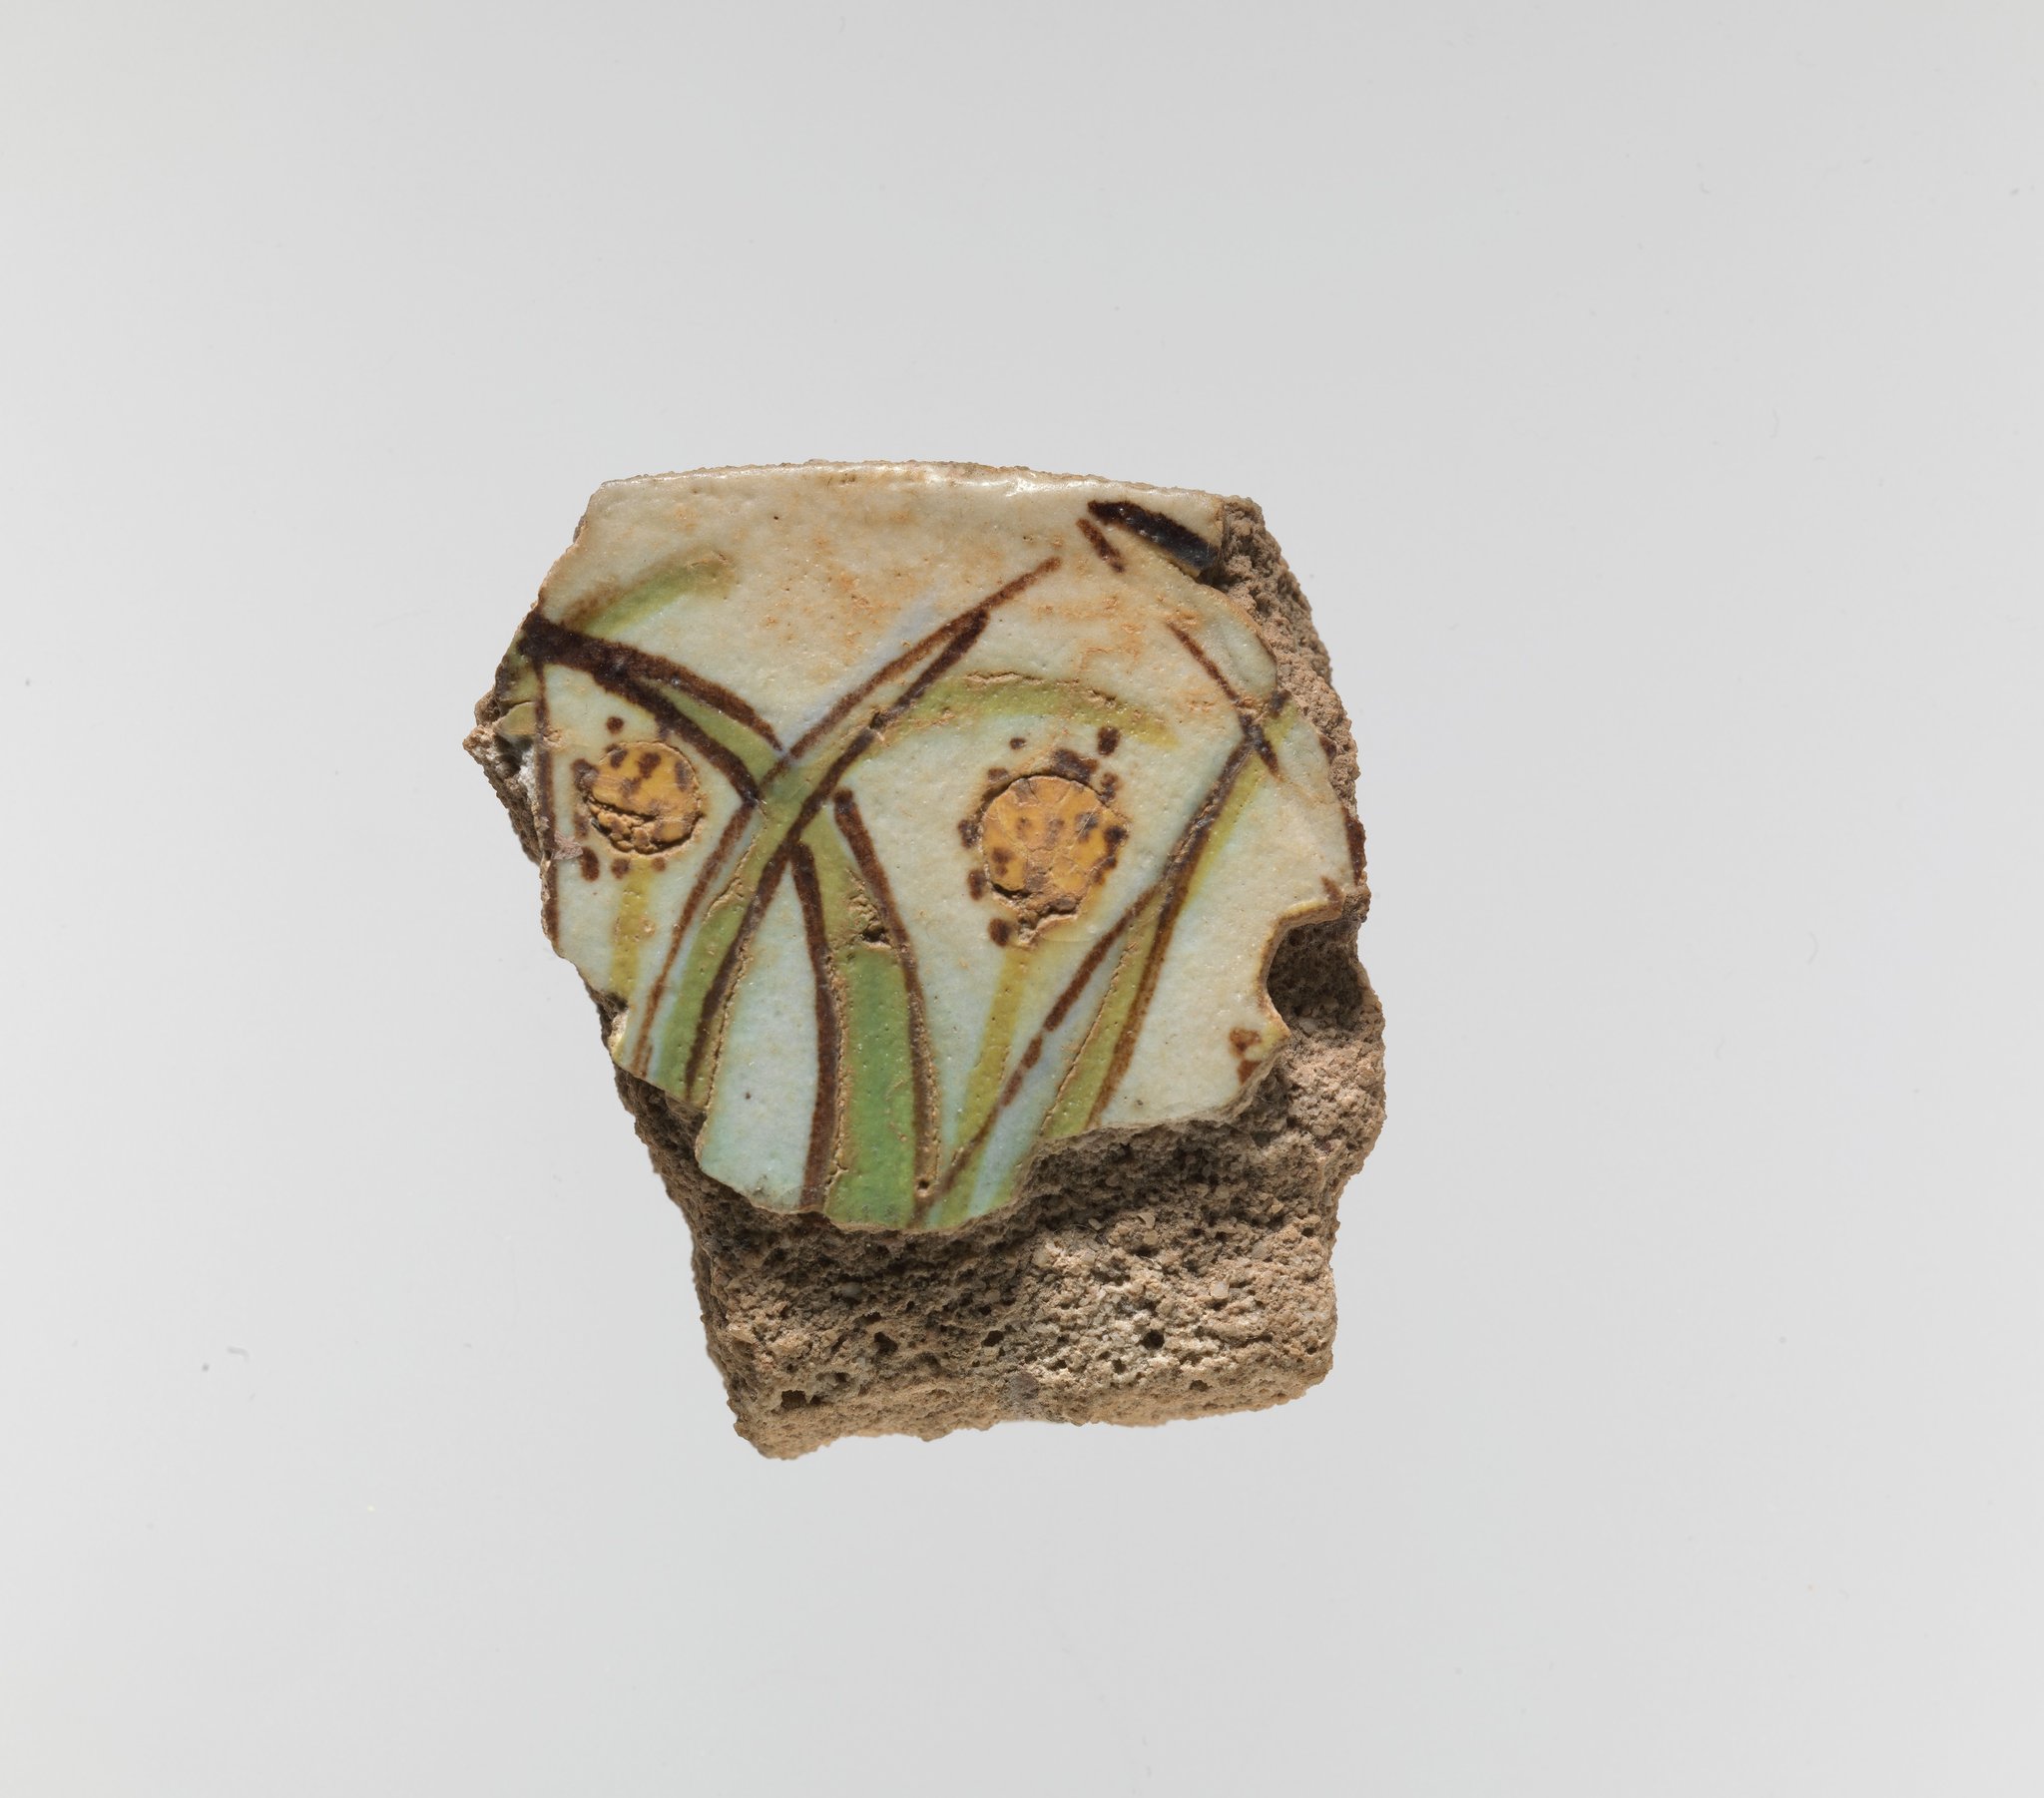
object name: tile fragment, marsh scene, bird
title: Tile from marsh scene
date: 1353-1336 BCE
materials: faience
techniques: polychrome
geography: egypt